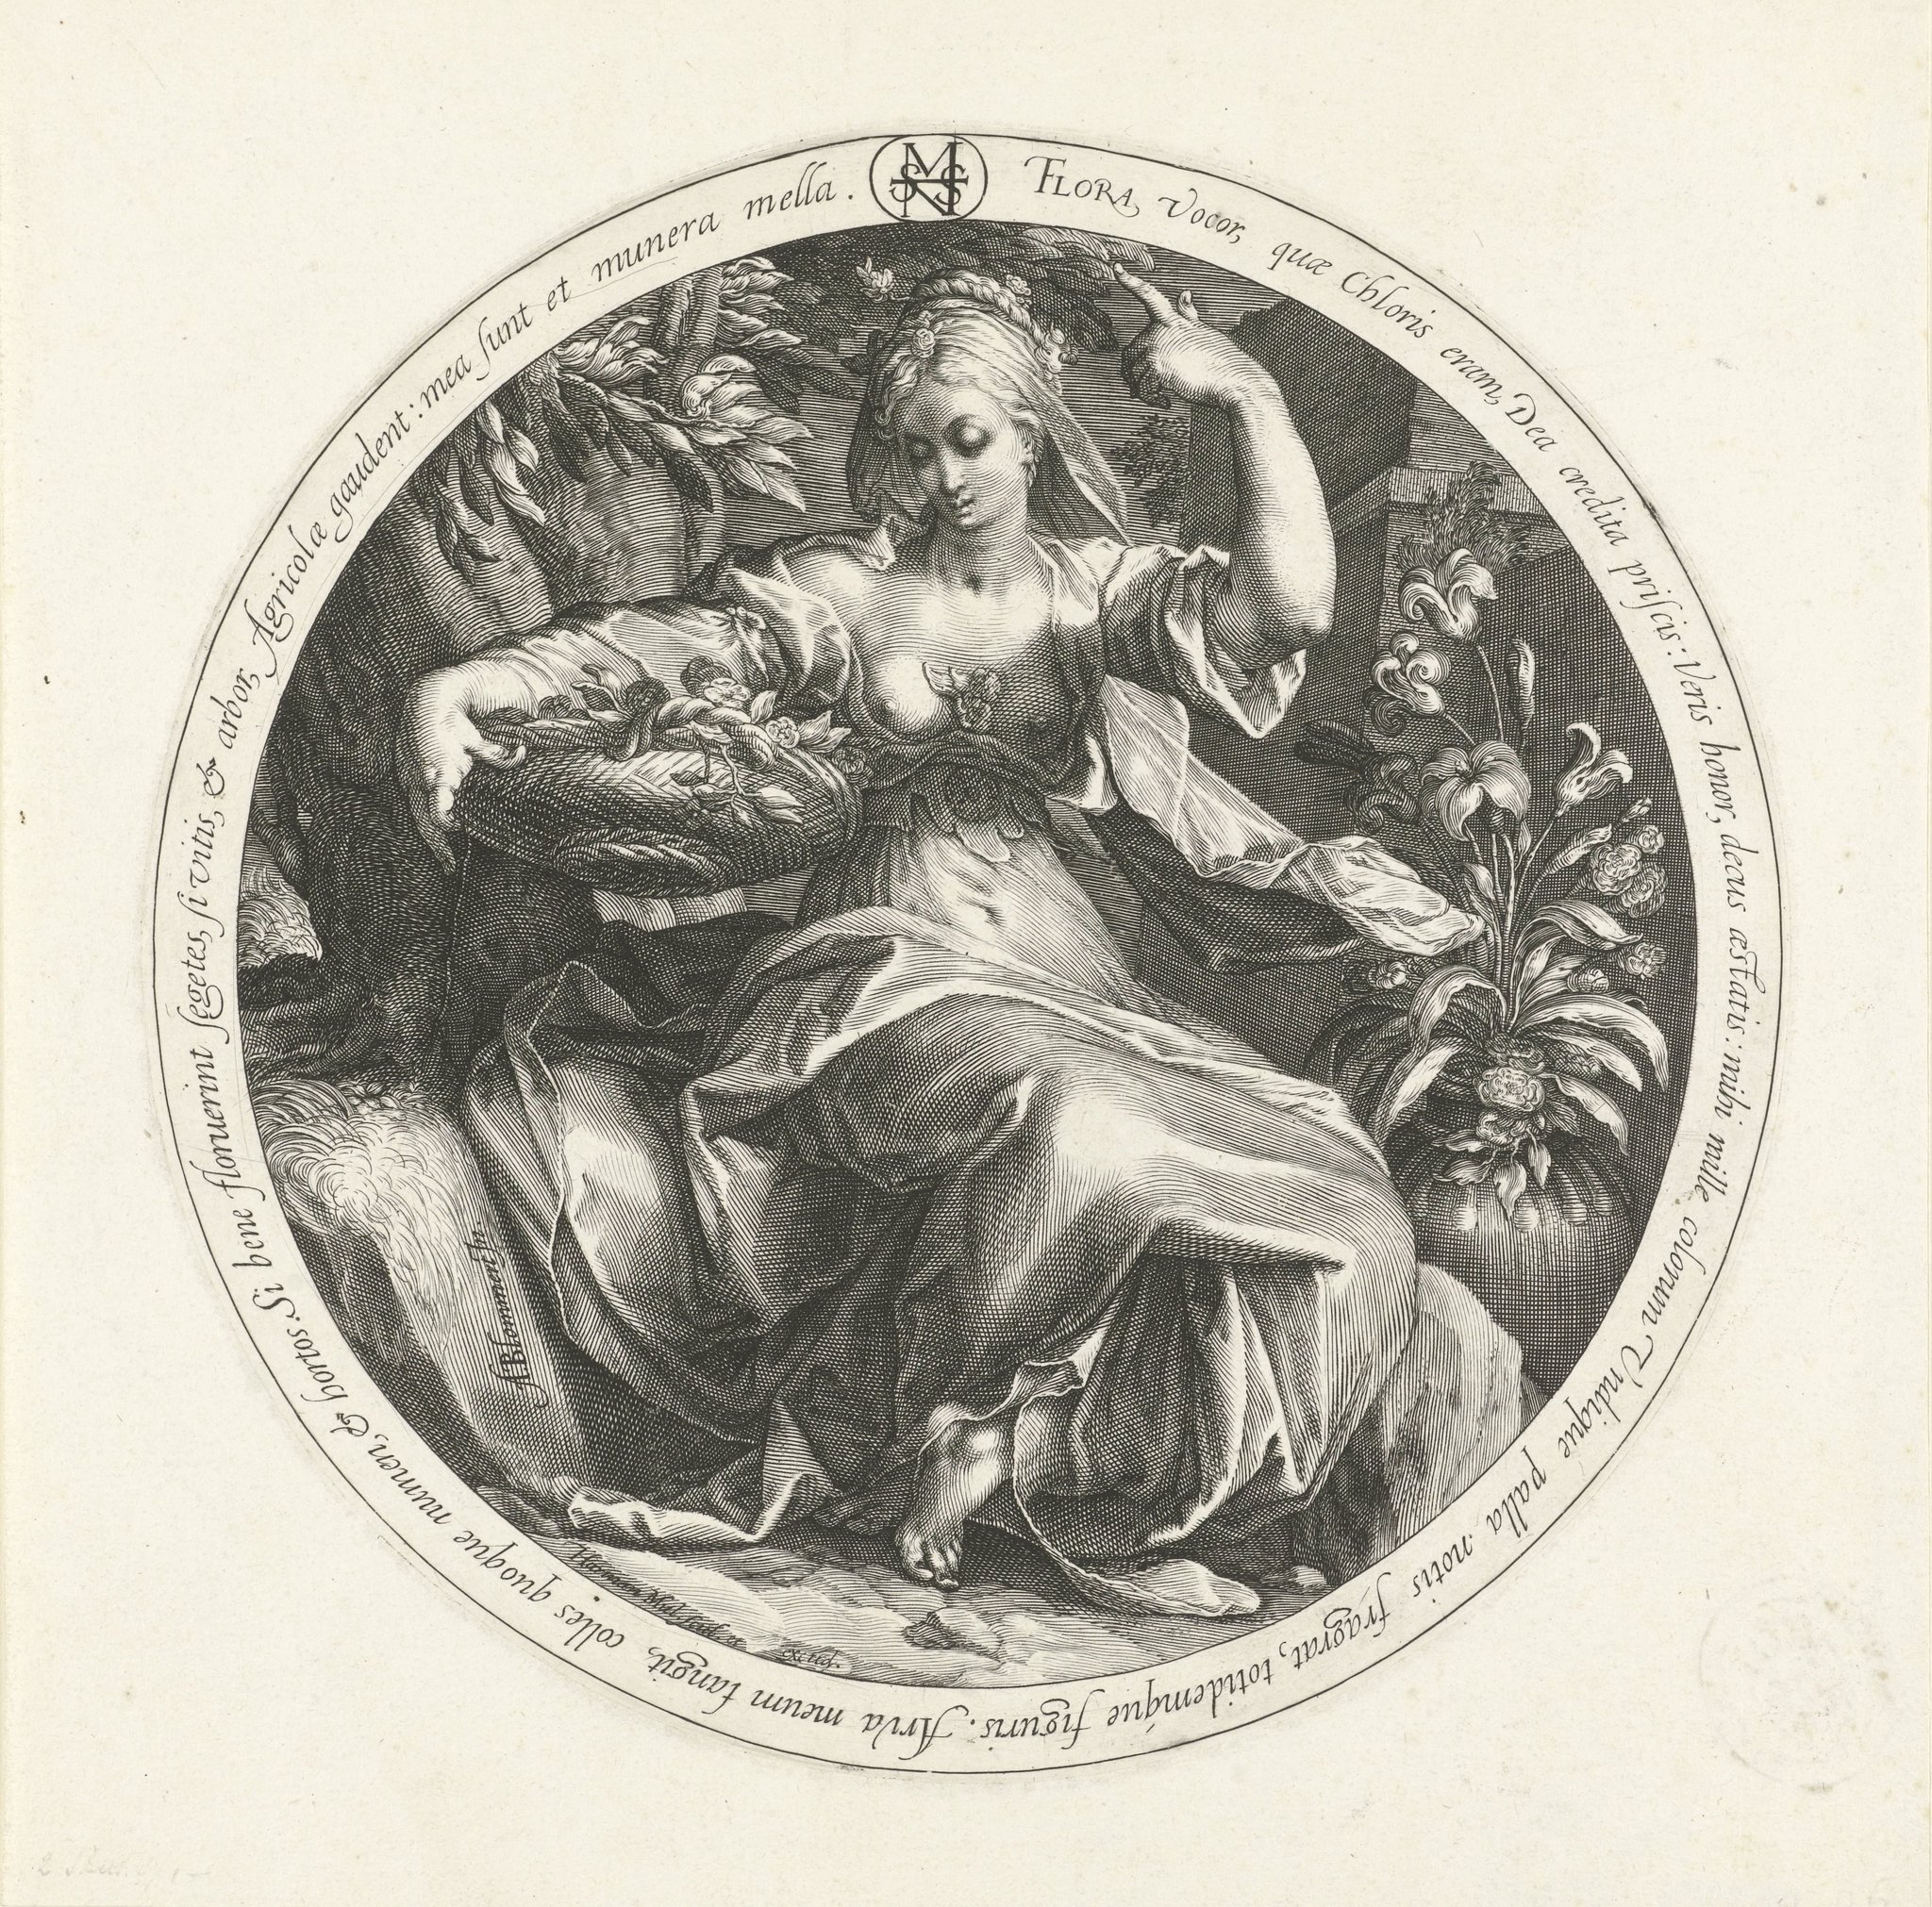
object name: print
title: Flora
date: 1598-1602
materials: paper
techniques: engraving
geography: amsterdam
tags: (story of) flora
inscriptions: collector's mark: Lugt 240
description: Flora, zittend met ontblote borsten, met een mand met bloemen onder haar arm. Naast haar staat een vaas met bloemen. Randschrift in het Latijn.